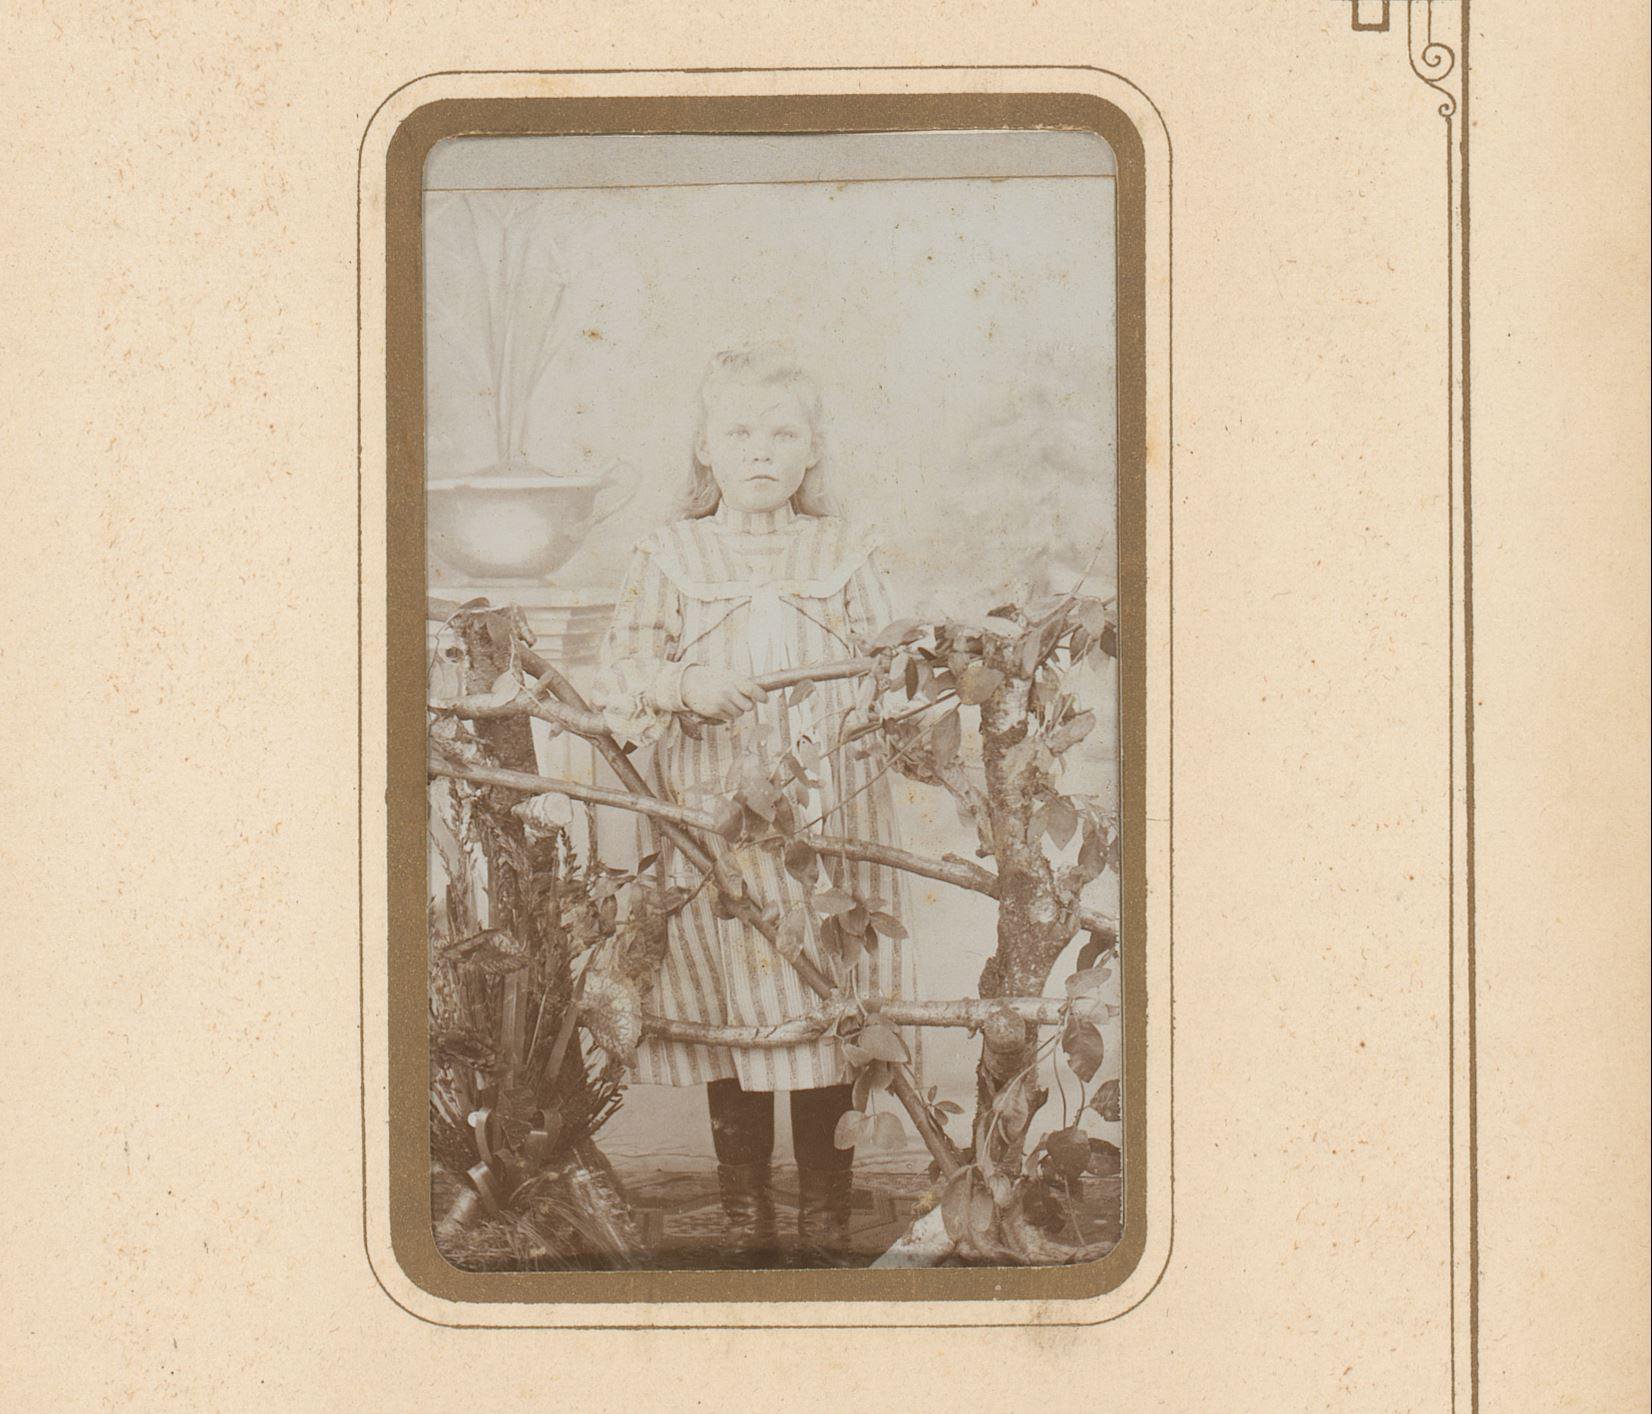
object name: album leaf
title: Portret van een meisje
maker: Anonymous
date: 1880-1920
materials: cardboard, photographic support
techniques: collodion silver print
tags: fence, wall, paling, historical persons, girl (child between toddler and youth)